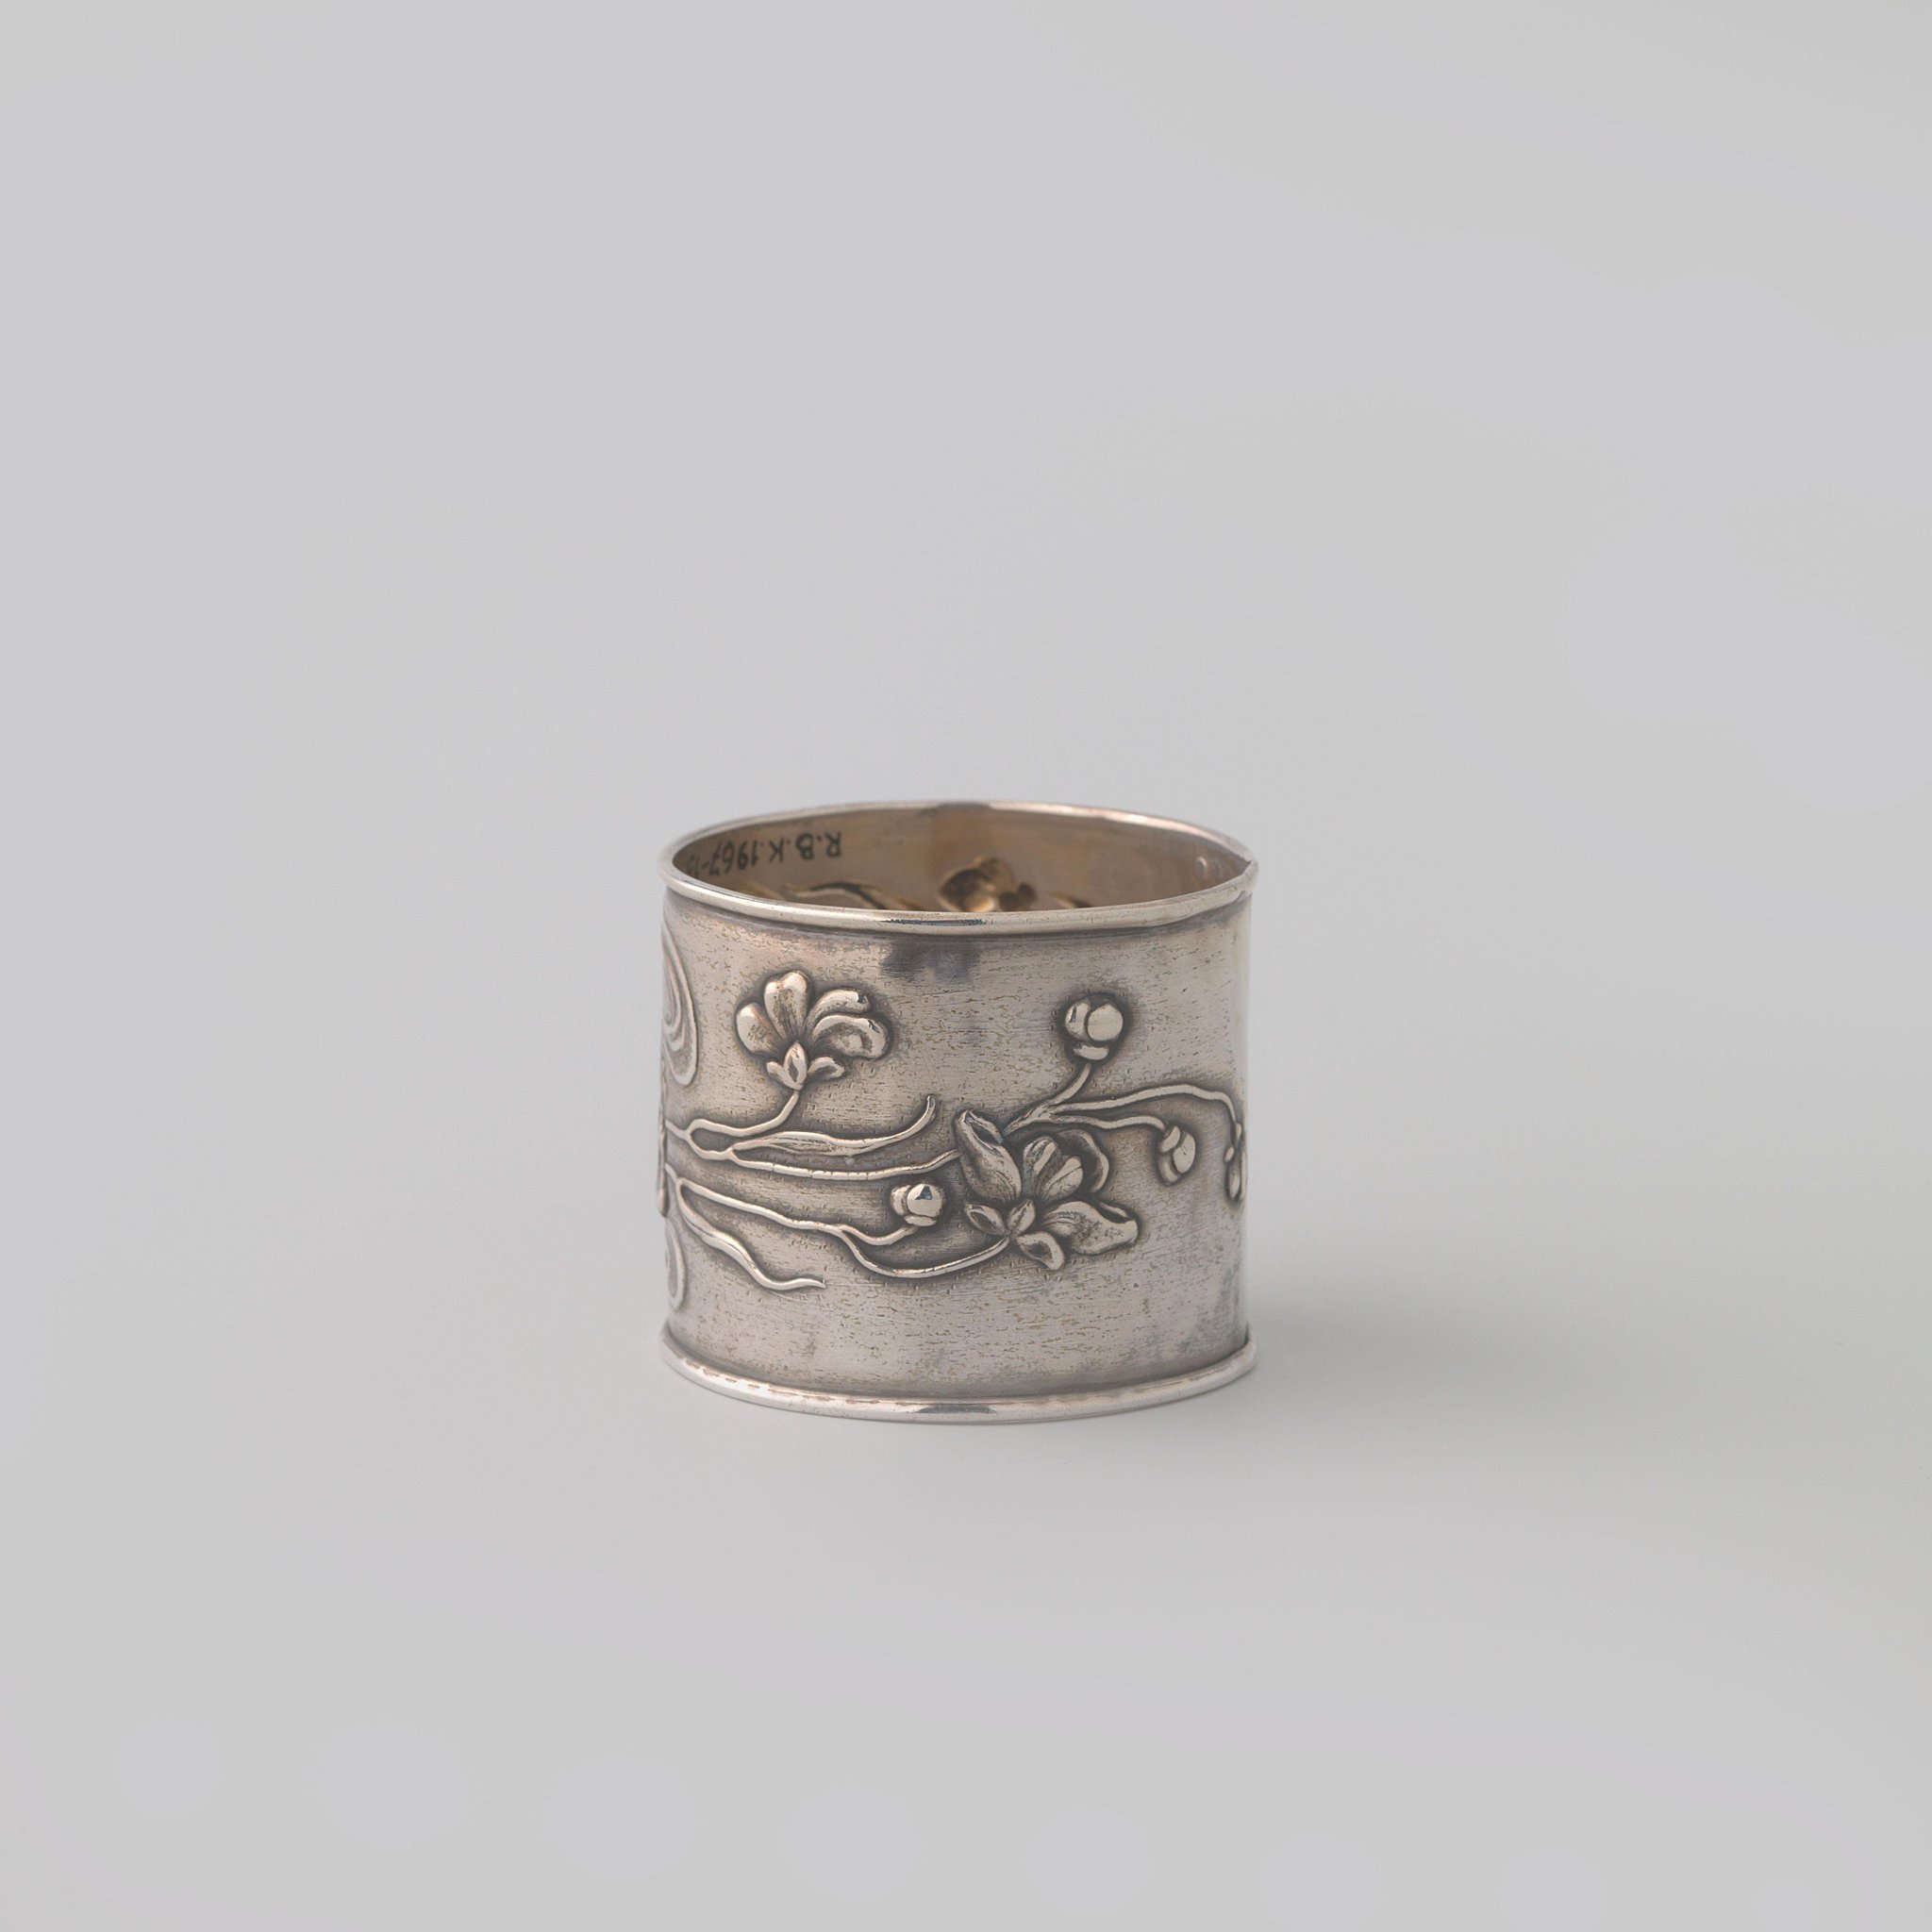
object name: napkin ring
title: Servetring met vrouwenkop tussen ranken.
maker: Anonymous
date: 1900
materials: silver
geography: porto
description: Servetring van zilver. Versierd met in reliëf een vrouwekop tussen ranken (Jungendstil). Meesterteken: blaker met kaars en A.